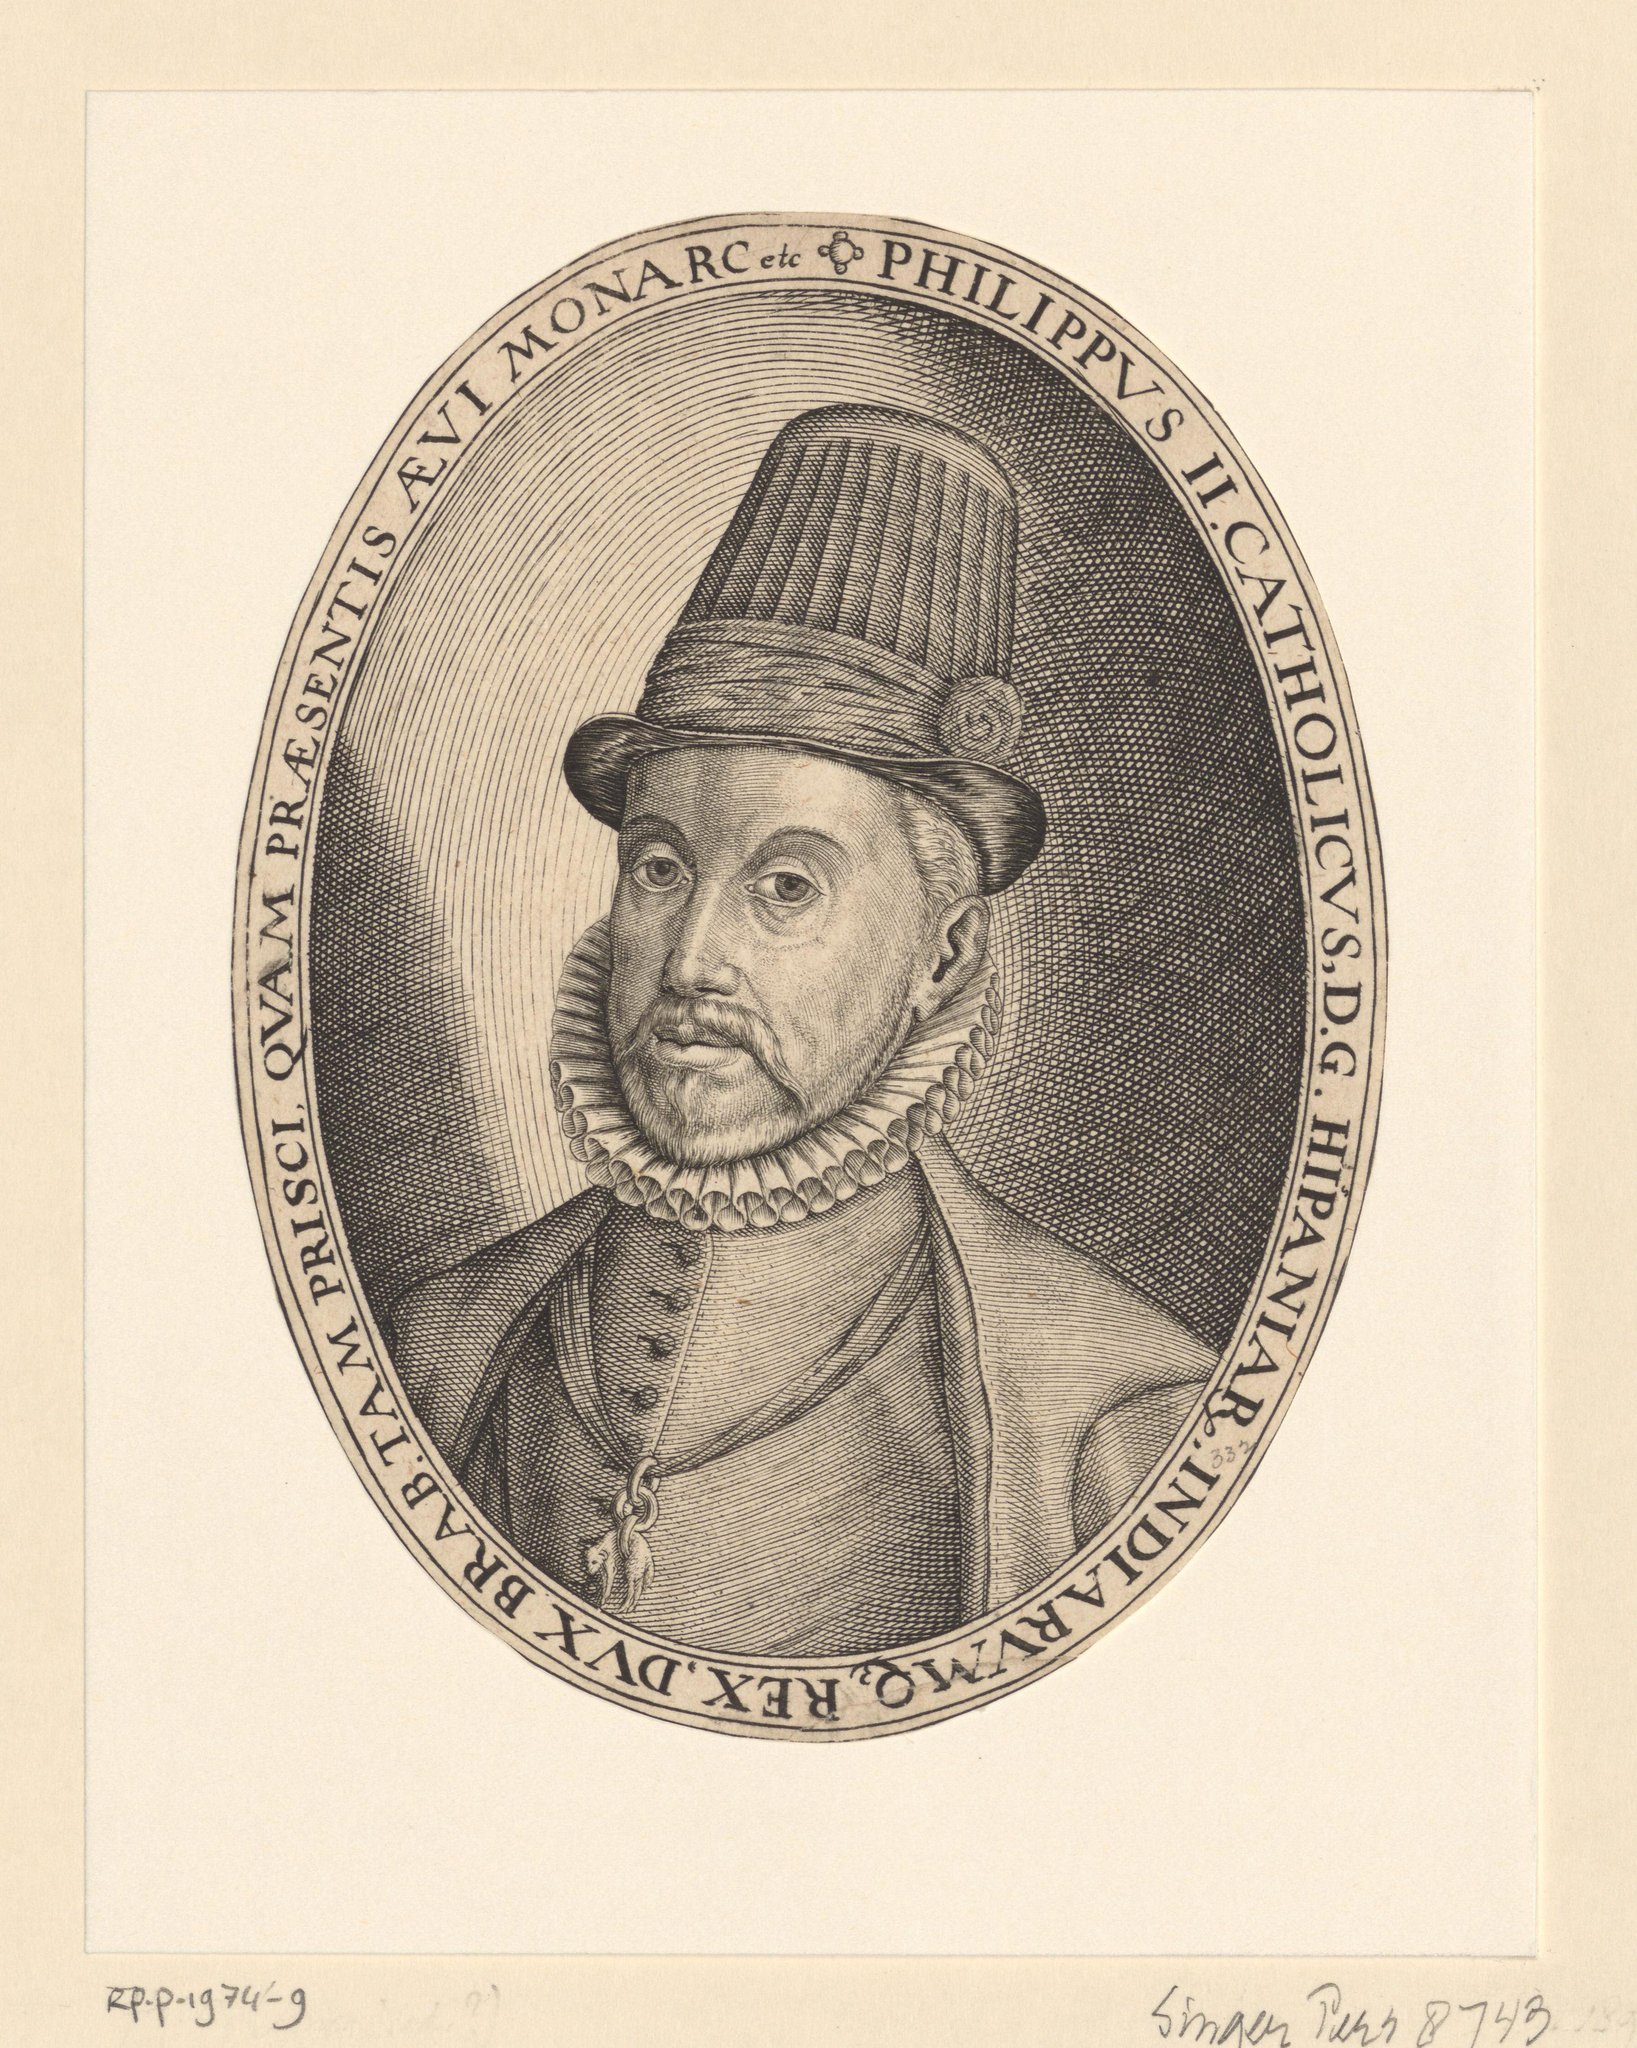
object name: print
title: Portret van Filips II, koning van Spanje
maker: lambert cornelisz.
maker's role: draughtsman, print maker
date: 1593-1612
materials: paper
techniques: engraving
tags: philip ii of spain, adult man, historical persons, knighthood order of the golden fleece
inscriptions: collector's mark: Lugt 2228, collector's mark: Lugt 2760